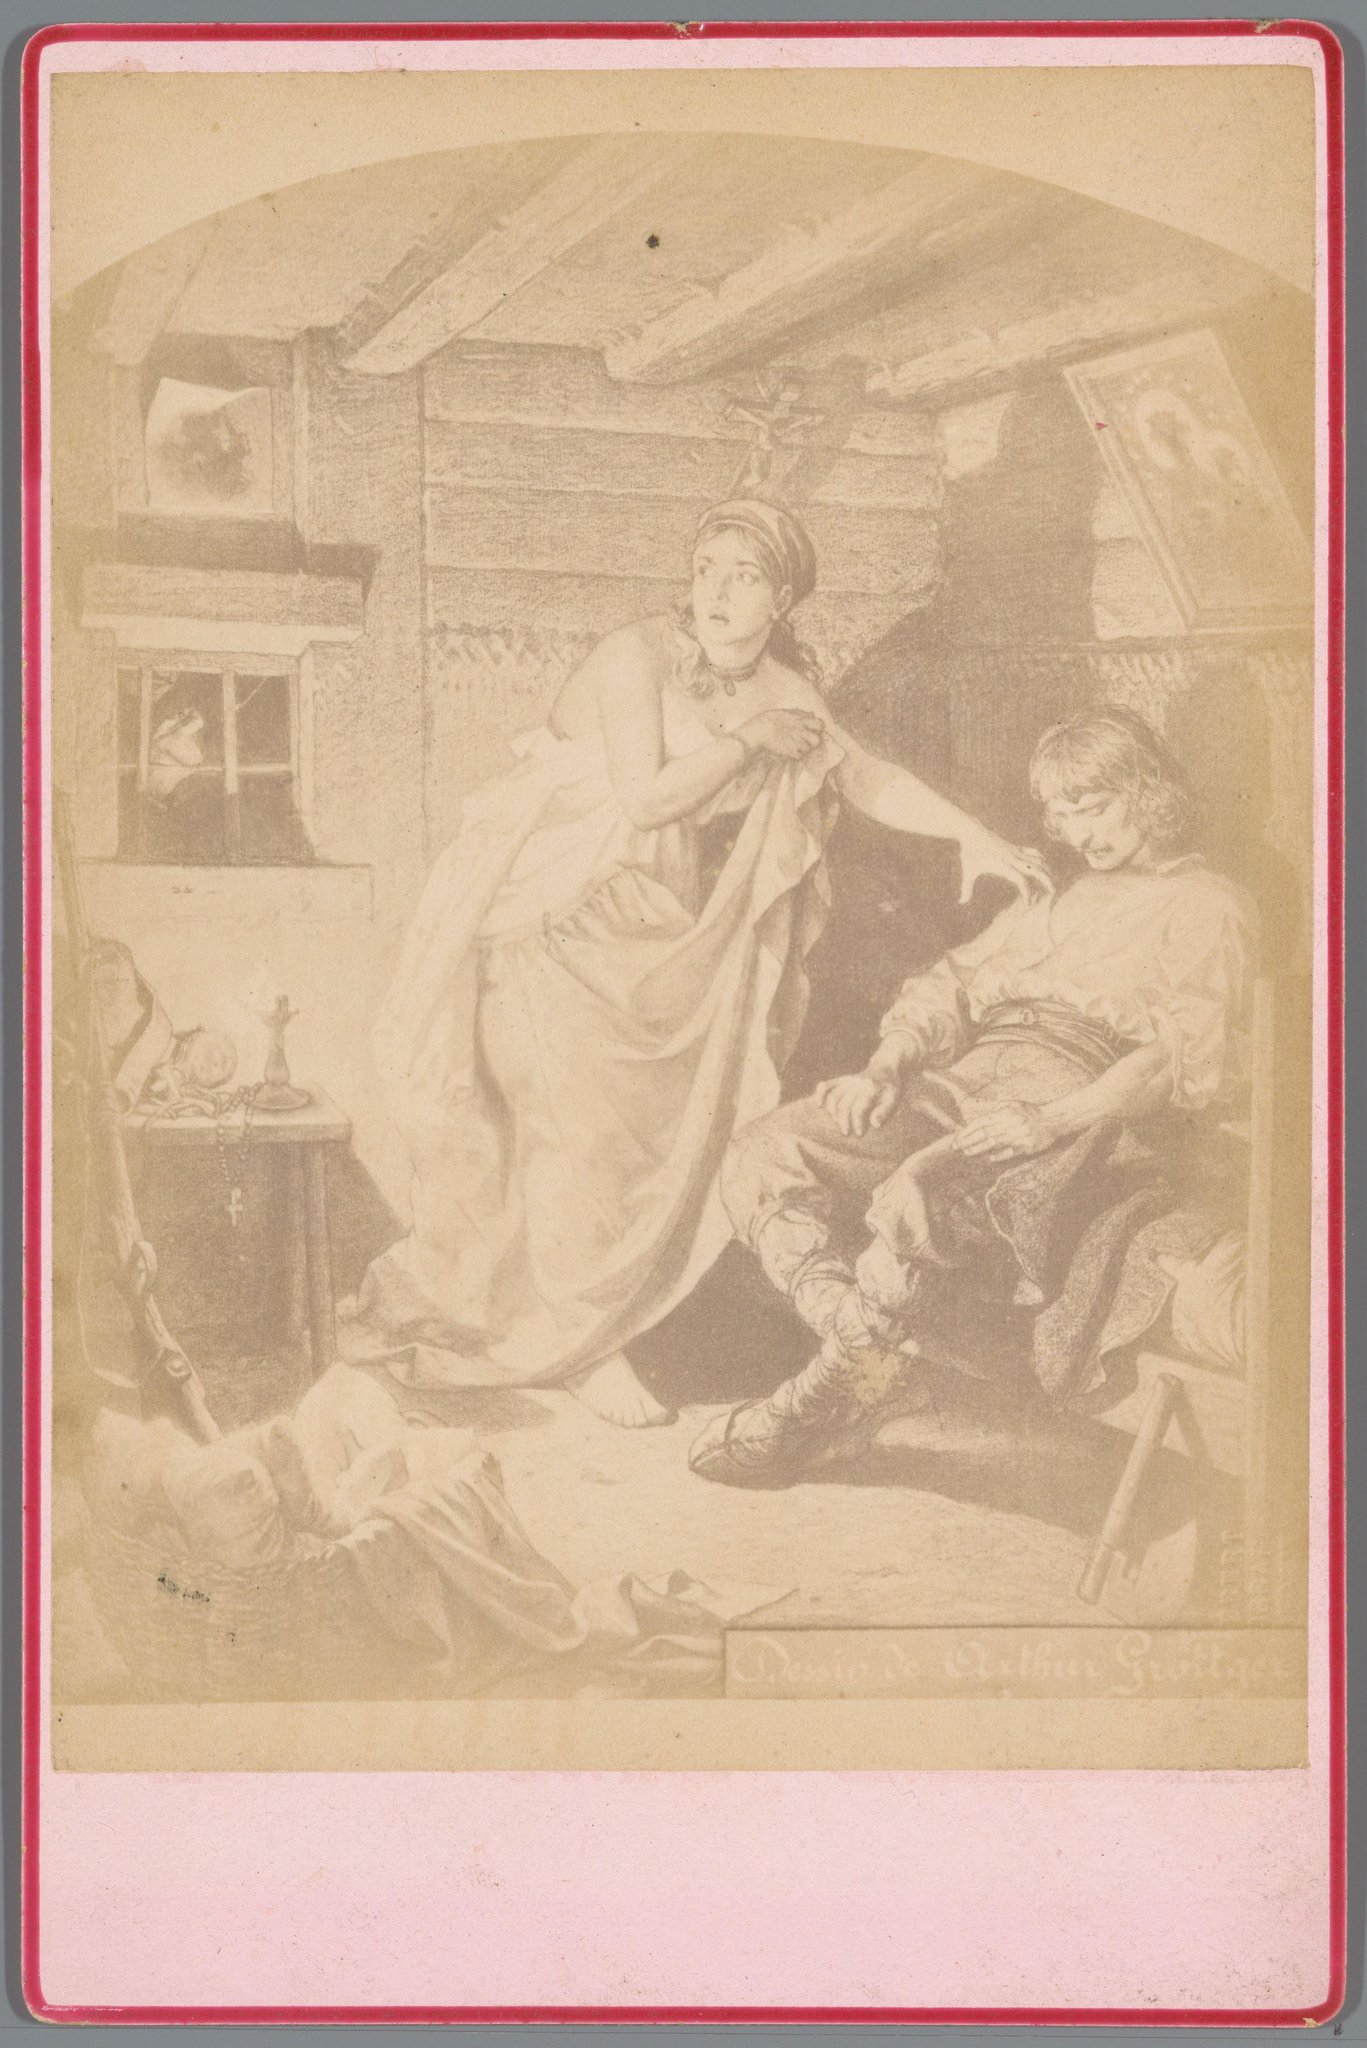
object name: reproduction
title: Fotoreproductie van de tekening door Arthur Grottger uit de serie Litouwen, voorstellende een vrouw die met een verschrikte uitdrukking naast een slapende man staat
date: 1870-1890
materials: cardboard, photographic support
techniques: albumen print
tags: drawing, sketch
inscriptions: name: ‘Vosmaer’, name: ‘[...]ufert [...]ograf’